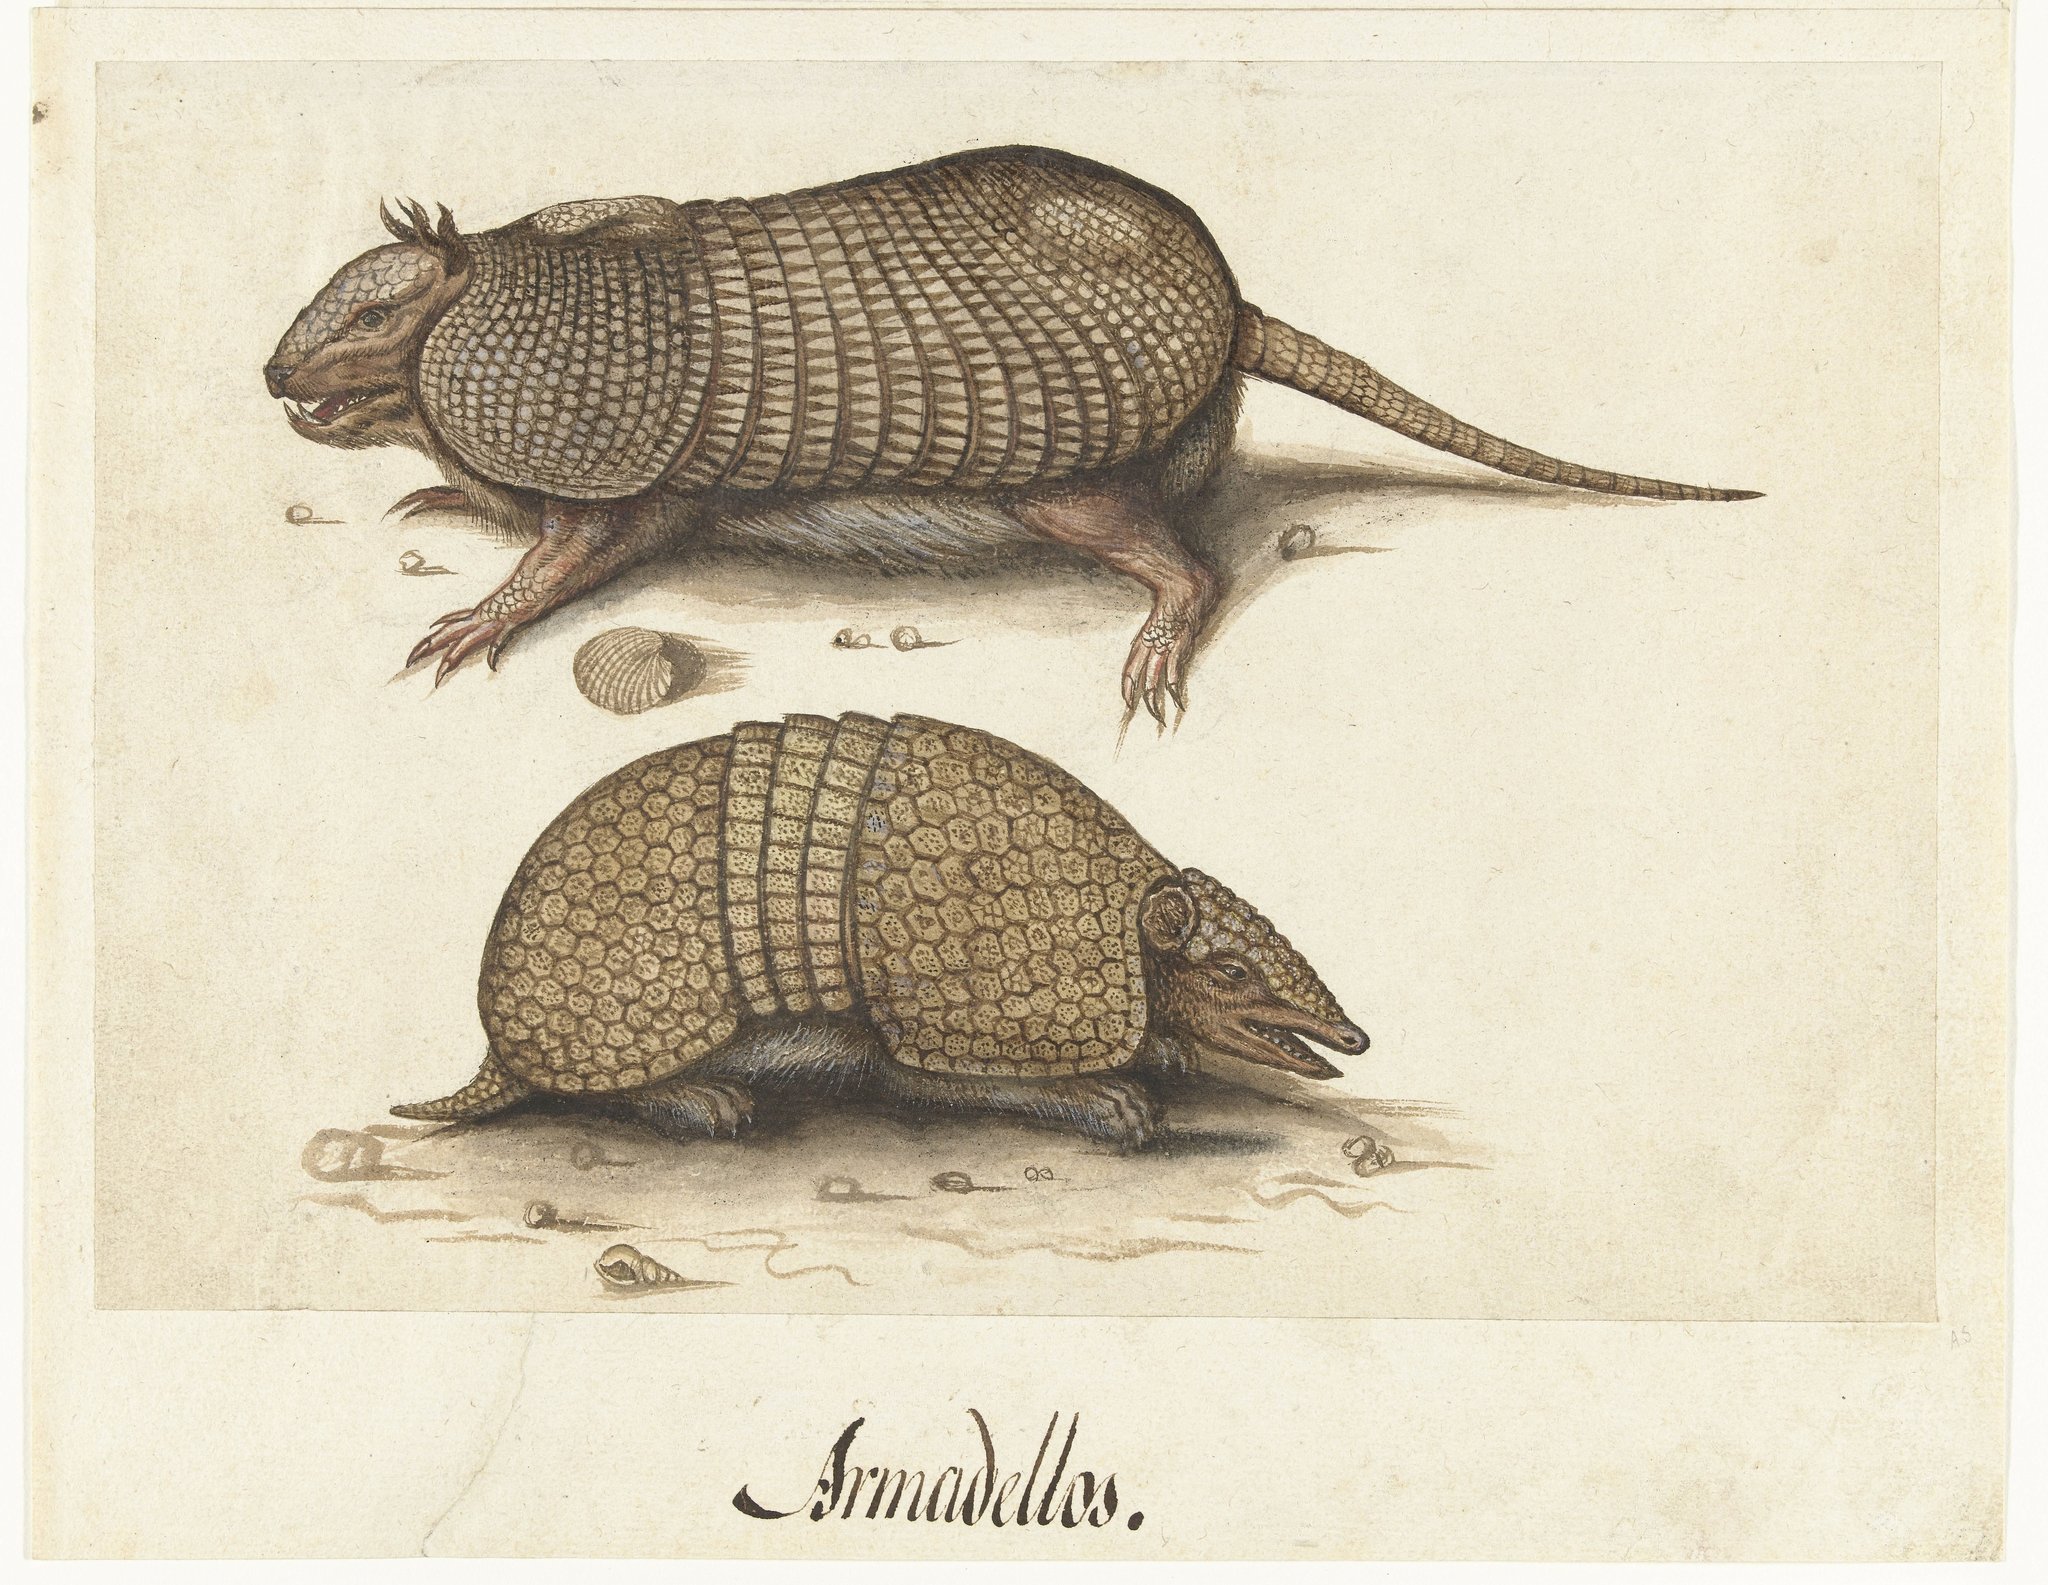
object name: drawing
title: Armadillos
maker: Anonymous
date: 1550-1570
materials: ink, paper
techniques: brush, pen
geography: low countries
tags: other mammals: armadillo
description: Armadillos are found in South America and are recognizable by their ‘armor’, or shell, consisting of ossified dermal plates. The unknown artist responsible for this sheet drew two species of the creature: a ninebanded, and a three-banded armadillo. Because of its unusual appearance, in the course of the 16th century the armadillo became the symbol of the newly discovered America. It was often depicted on prints and maps, and dried specimens were collected in cabinets of curiosities.